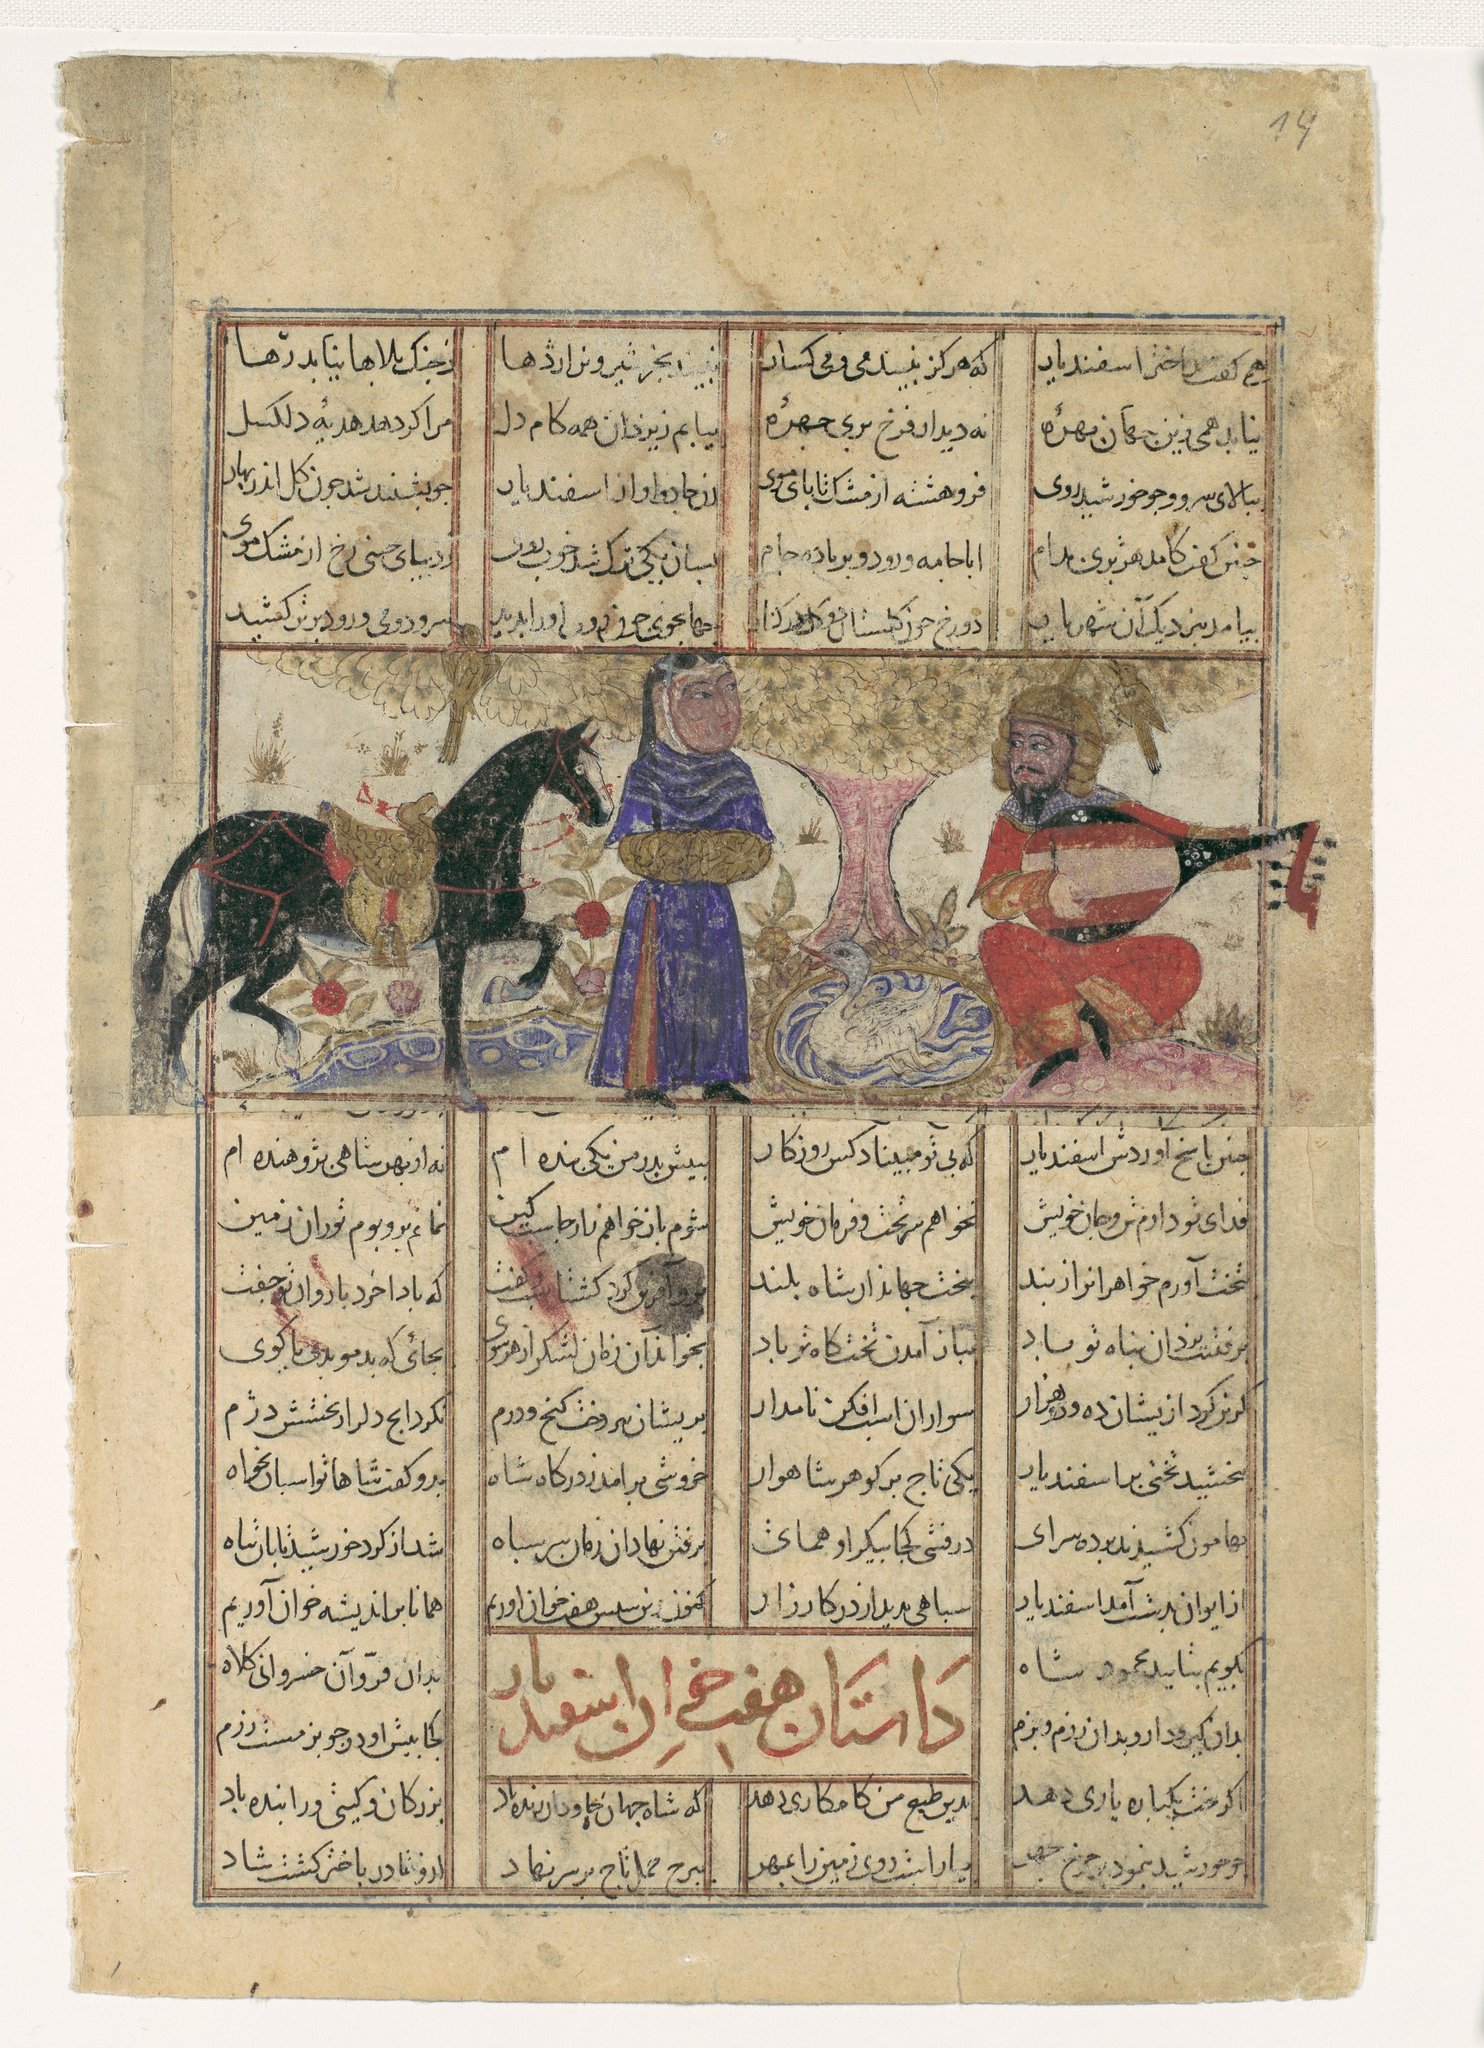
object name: folio from an illustrated manuscript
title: "Isfandiyar's Fourth Course: He Slays a Sorceress", Folio from a Shahnama (Book of Kings) of Firdausi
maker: abu'l qasim firdausi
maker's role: author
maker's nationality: iranian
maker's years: 935-1020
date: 1330-1340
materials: gold, ink, paper, silver, watercolor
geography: iran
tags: ducks,men,women,lutes,horses